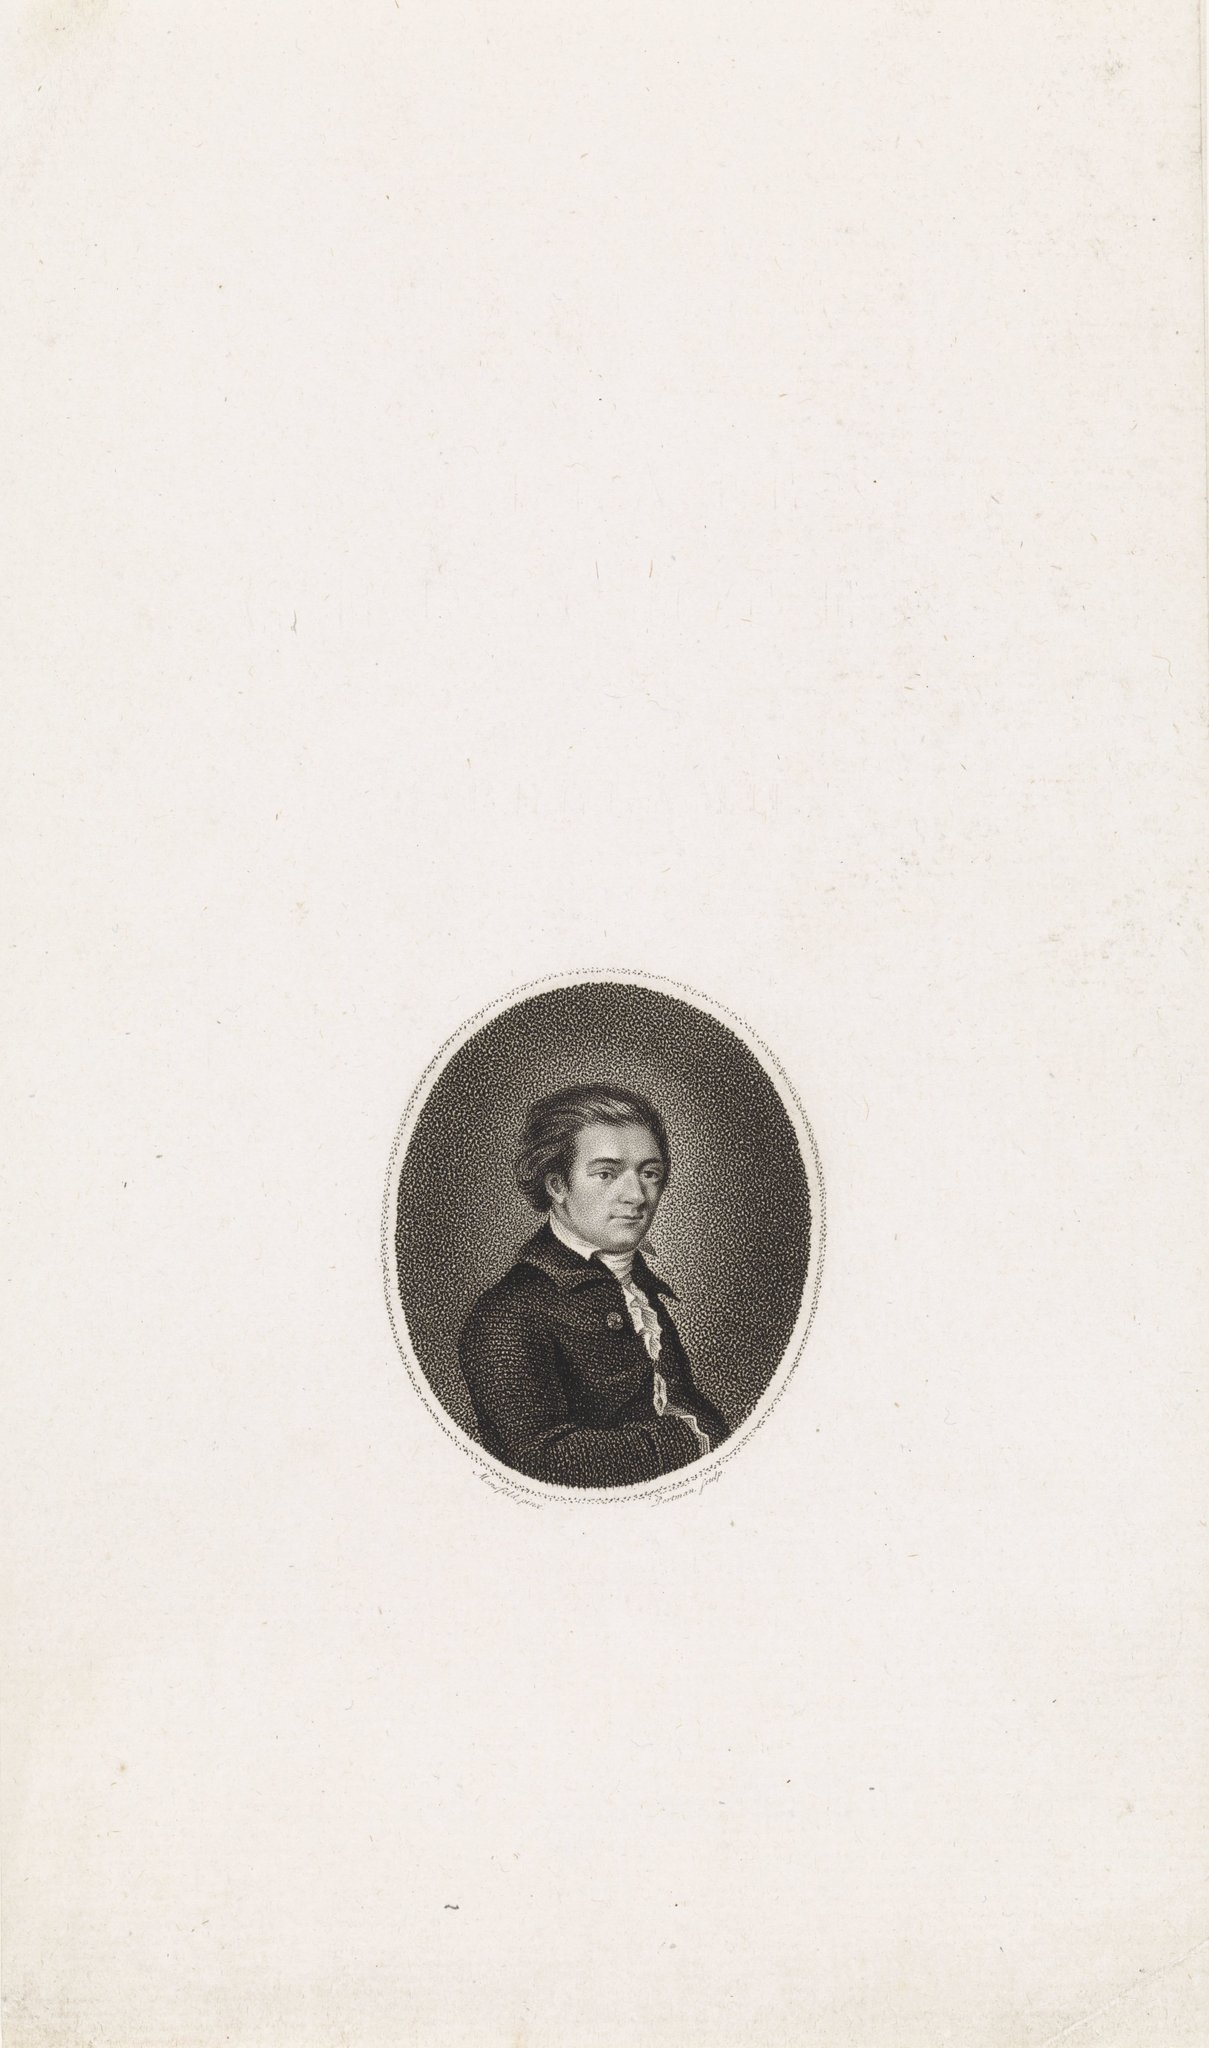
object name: print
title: Portret van Jacobus Bellamy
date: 1807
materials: paper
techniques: stippled etching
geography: amsterdam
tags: flushing, portrait of a writer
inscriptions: collector's mark: Lugt 2228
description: Tweede staat van deze prent gebruikt als titelpagina voor: Bellamy, Jacobus. Jeugdige en nagelaten gedichten van J. Bellamij. Haarlem: Adriaan Pietersz. Loosjes, 1807.